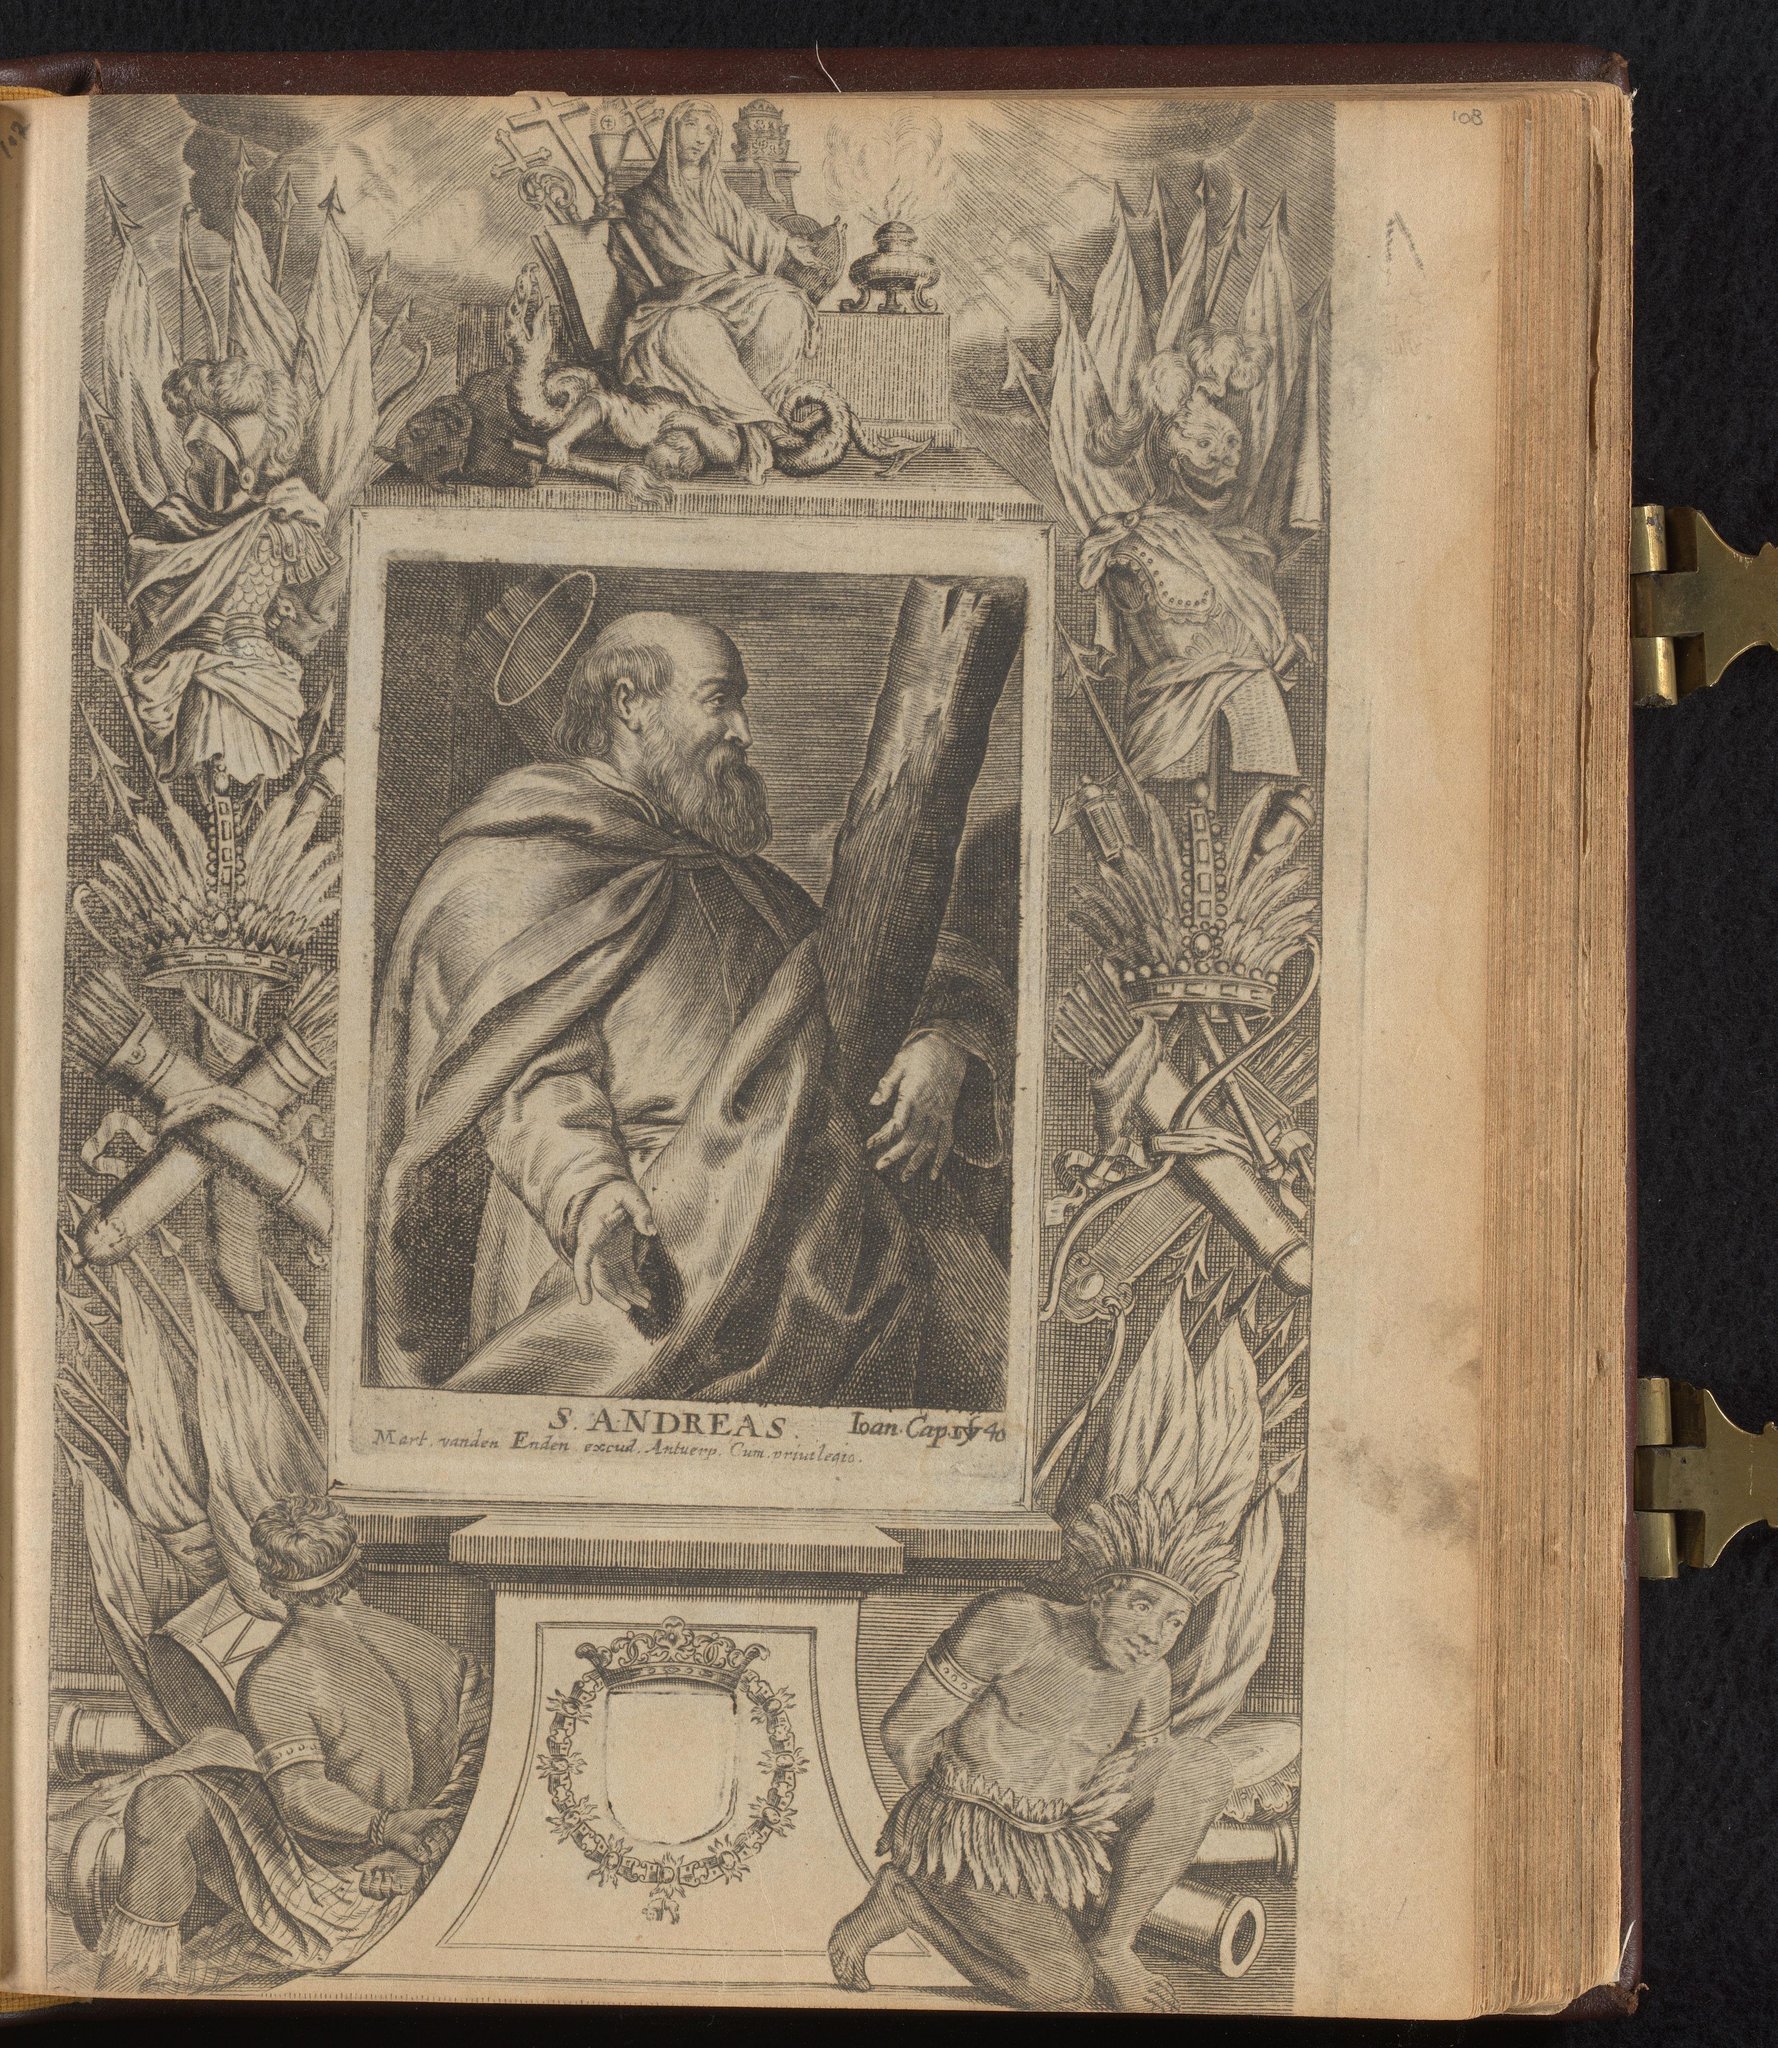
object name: print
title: Heilige Andreas met kruis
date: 1783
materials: paper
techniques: engraving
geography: antwerp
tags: fides (faith) as roman personification, archer's weapons: bow and arrow, the apostle andrew; possible attributes: book, x-shaped cross, fish, fishing-net, rope, scroll, armour, indigenous peoples of north america, armorial bearing, heraldry, smoking pot as symbol of 'vanitas'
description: Prent maakt deel uit van een prentbijbel.